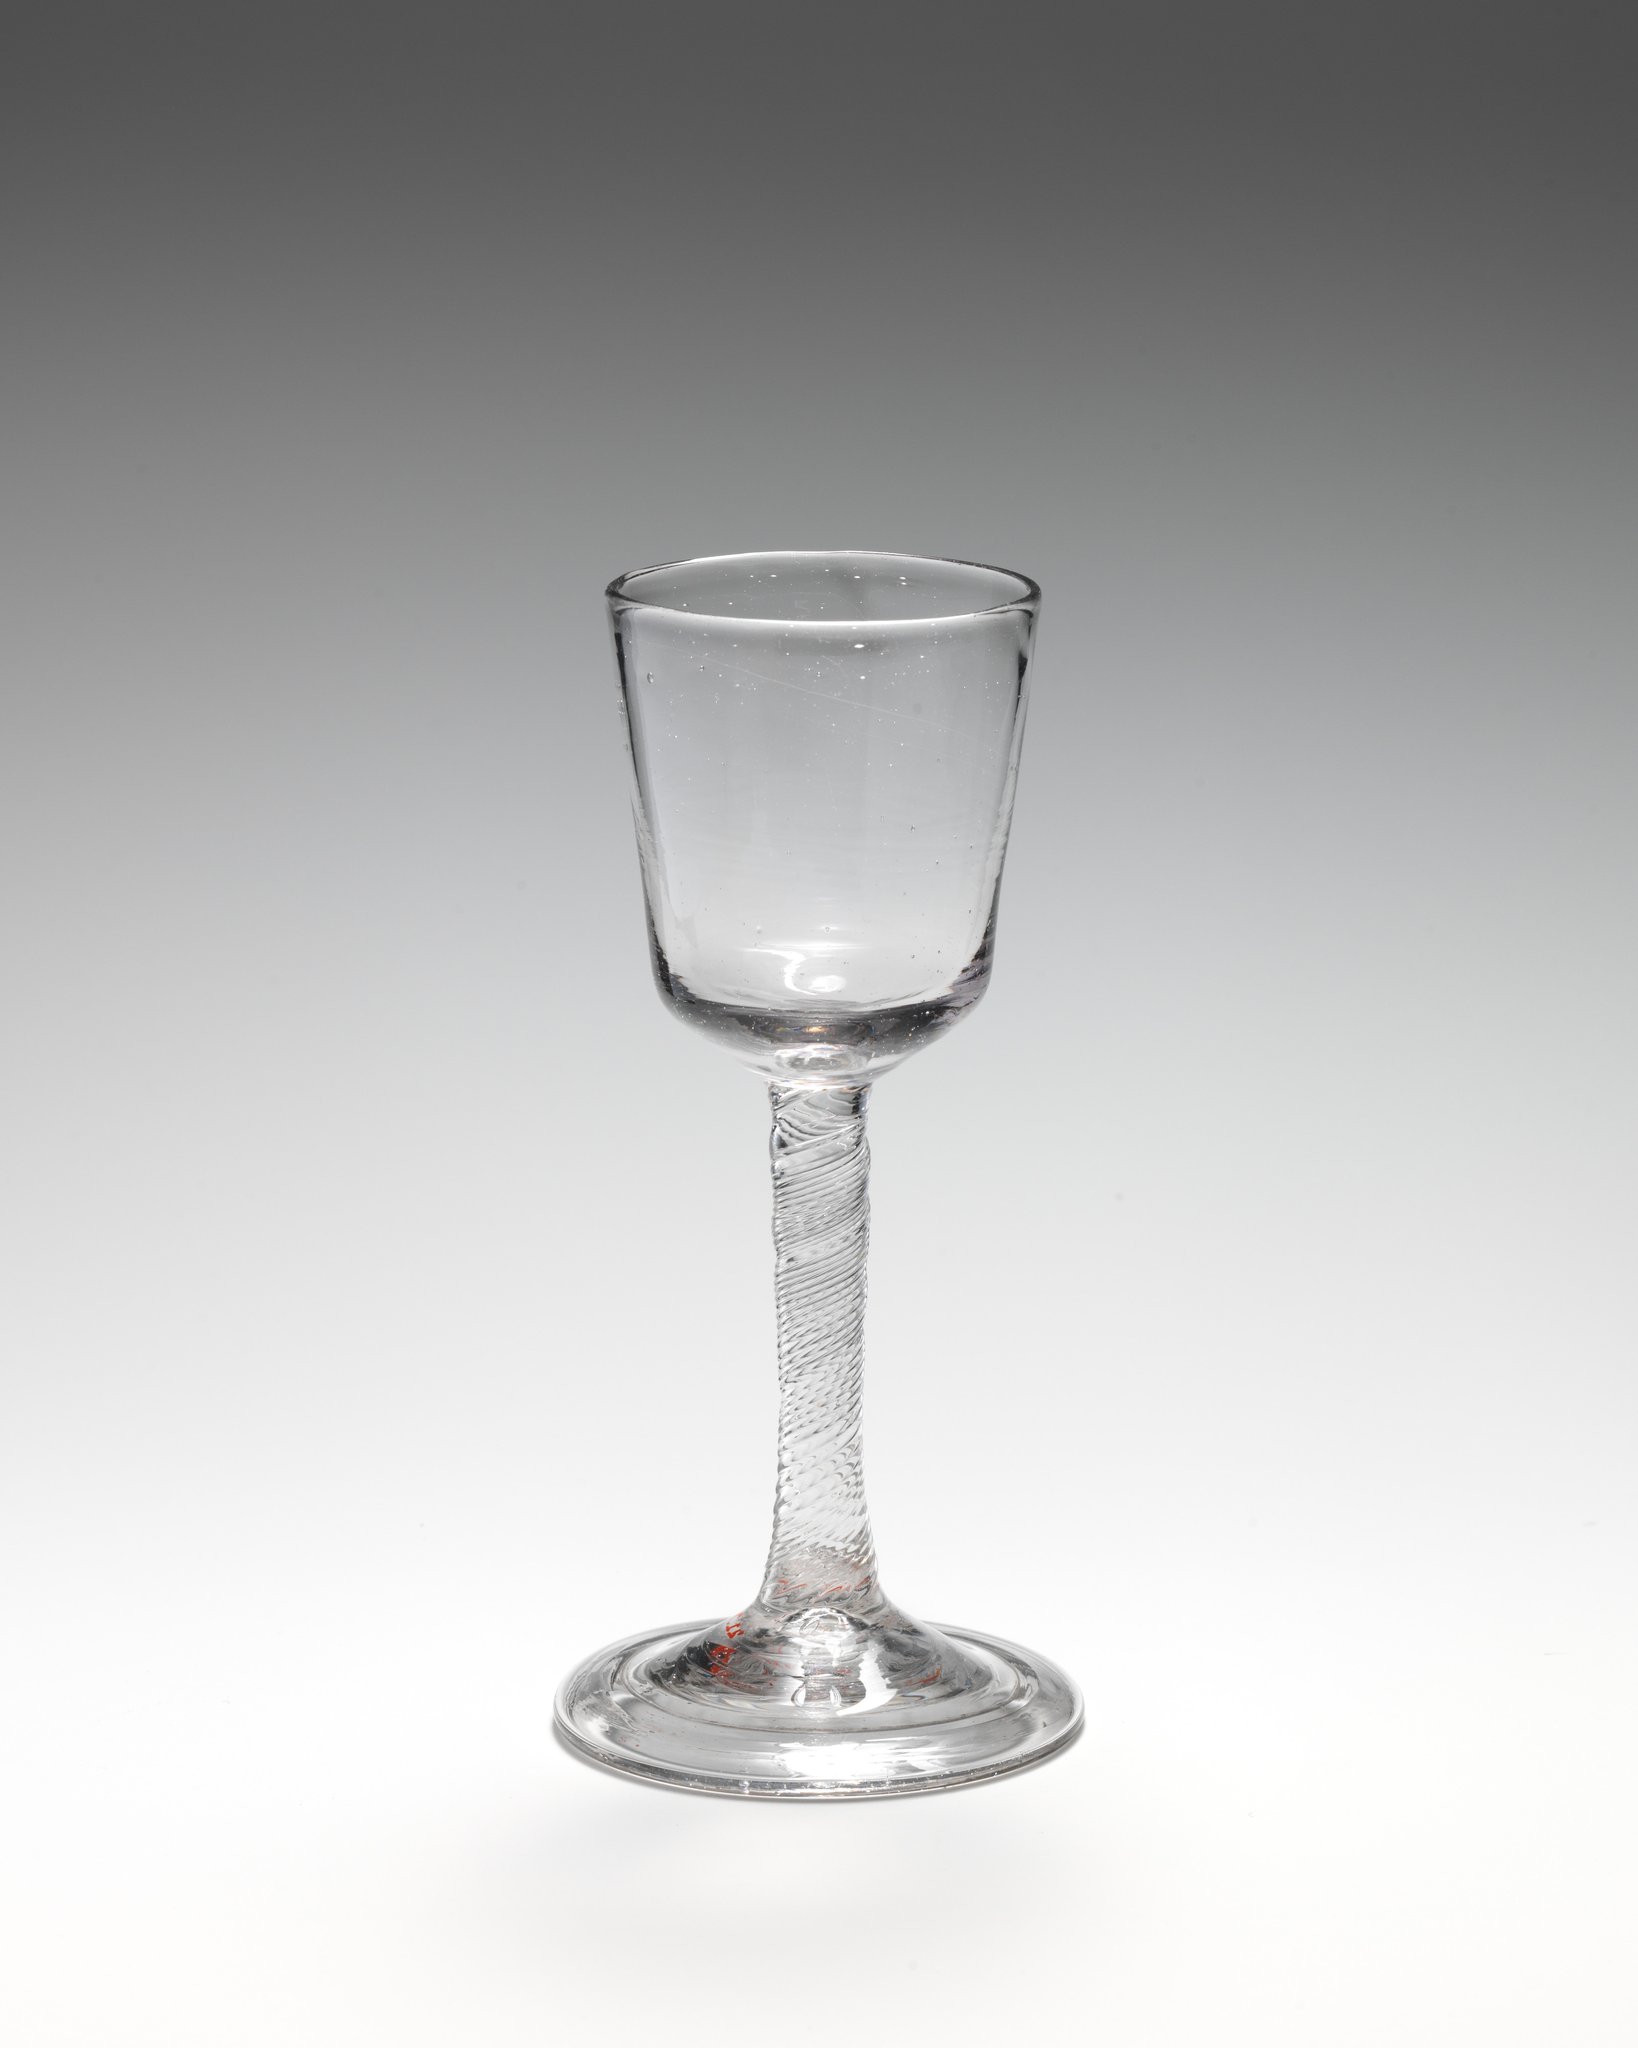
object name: wineglass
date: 1701-1750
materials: glass